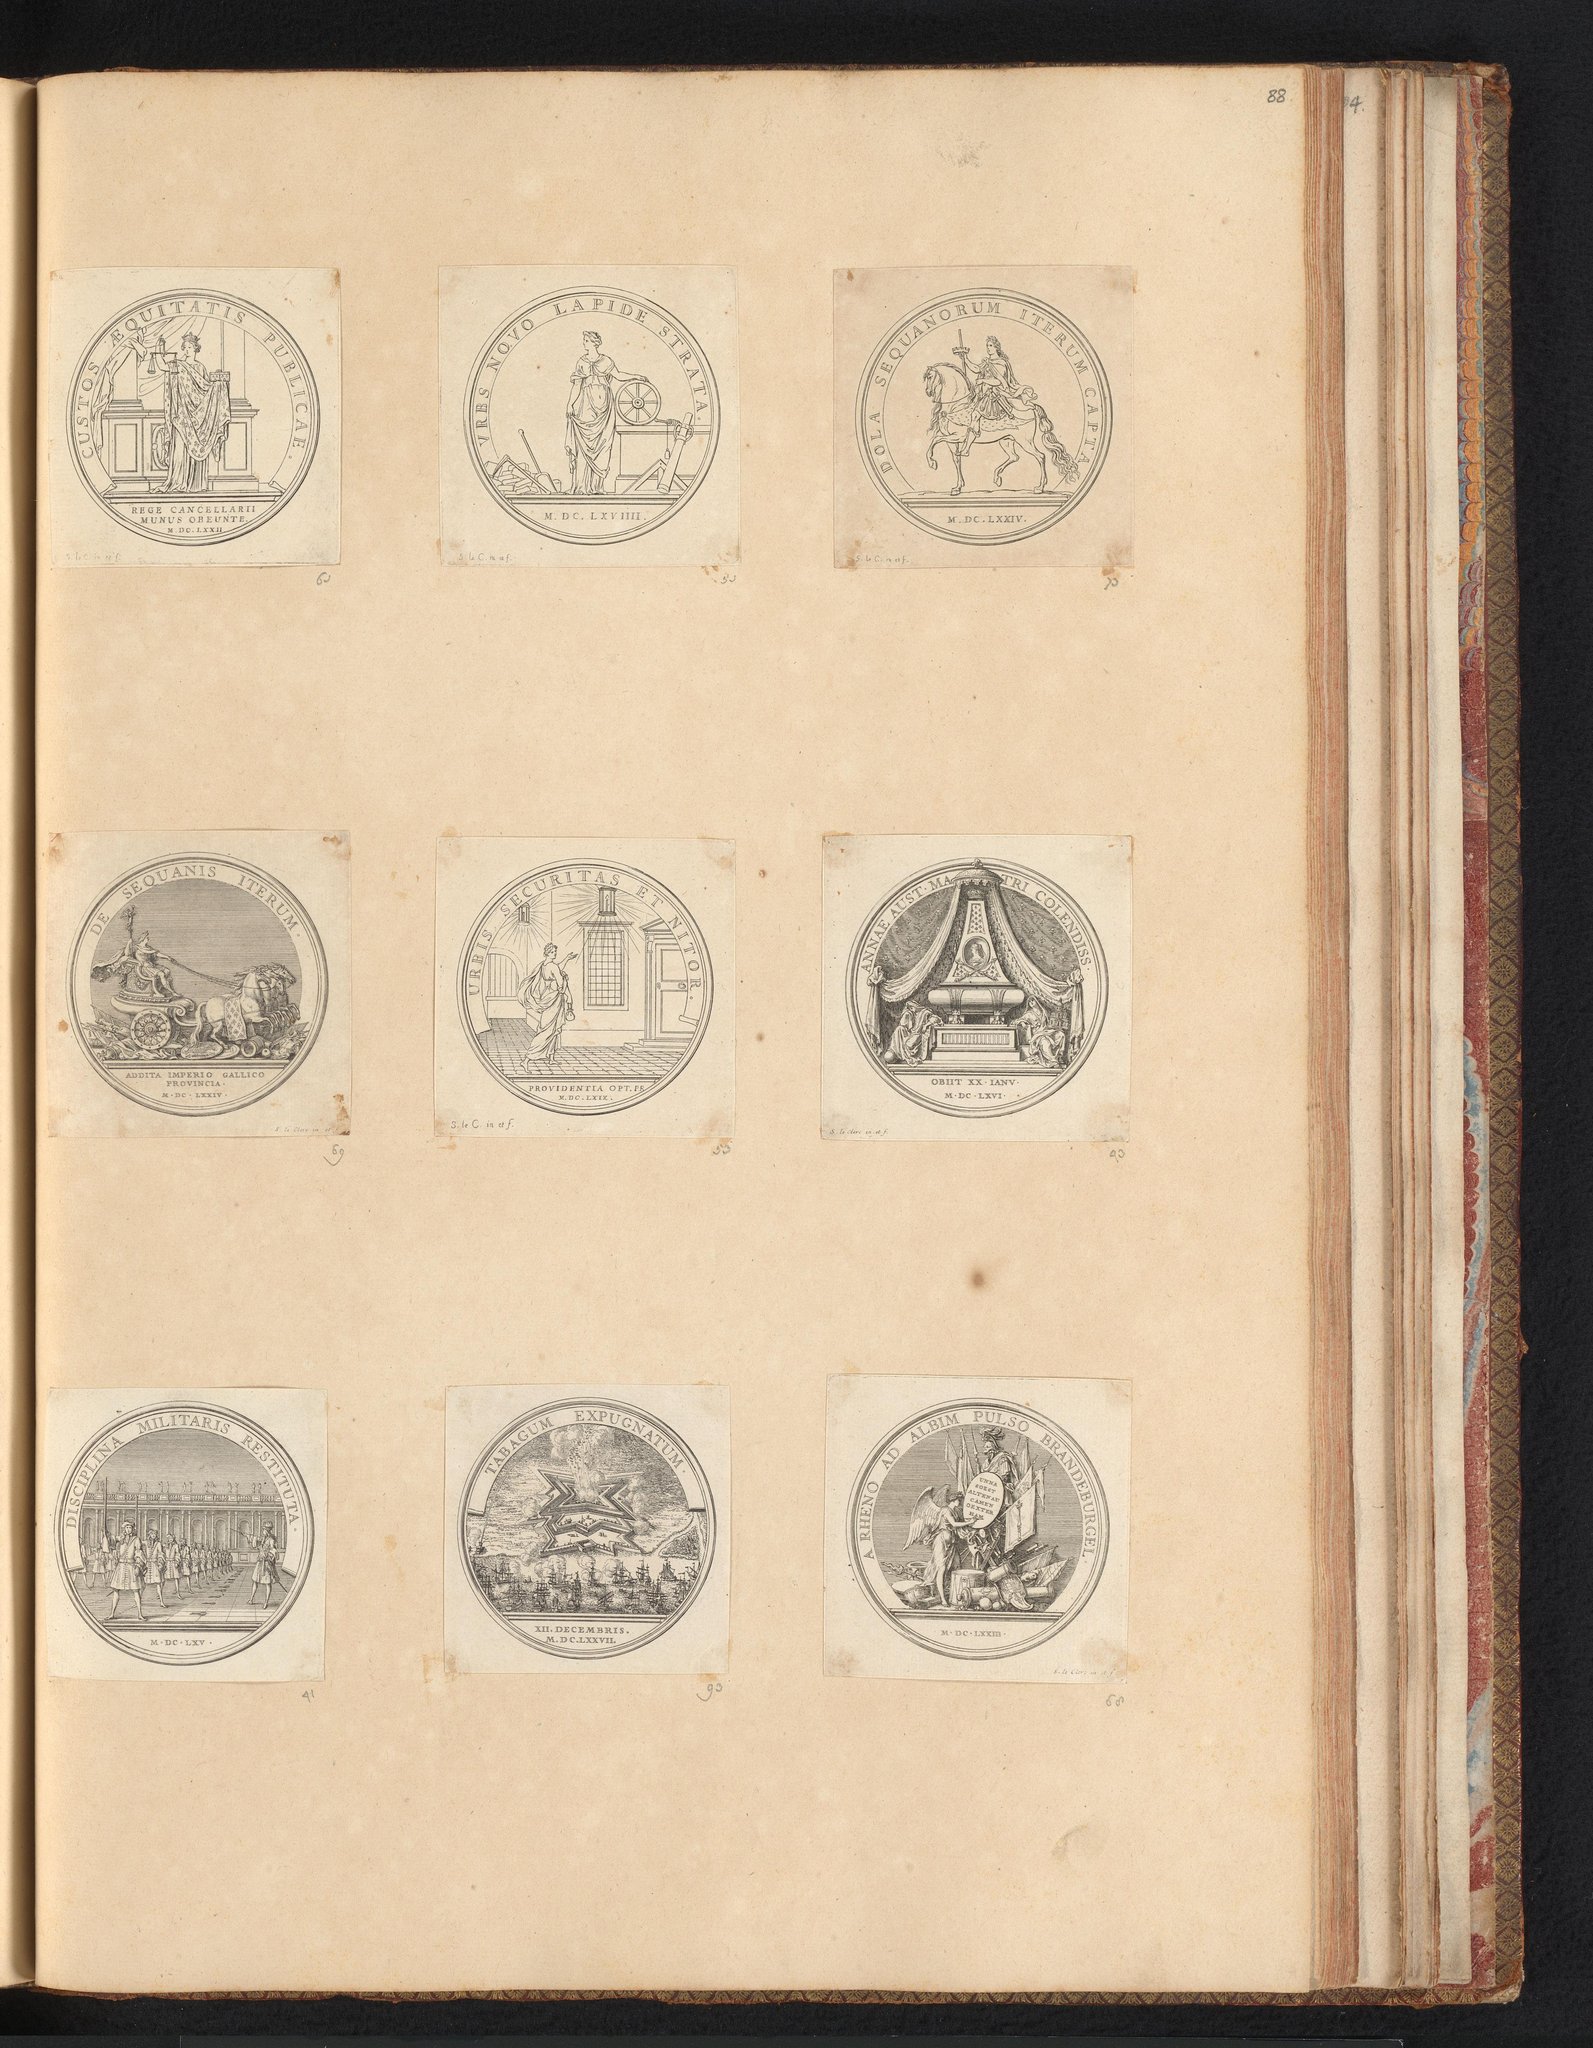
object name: album leaf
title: Negen medailles ter ere van Lodewijk XIV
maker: sébastien leclerc (i)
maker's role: print maker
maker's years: 1637-1714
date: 1702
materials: paper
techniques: etching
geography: paris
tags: paris, anna van oostenrijk (koningin van frankrijk), lodewijk xiv (koning van frankrijk), historical persons, queen, medal (considered as a piece of sculpture, regardless of its specific function), victory, grave, tomb, military training, king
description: Prenten bestemd voor: Médailles sur les principaux événements du règne de Louis le Grand. Parijs: Imprimerie Royale, 1702. Zes prenten niet gepubliceerd.